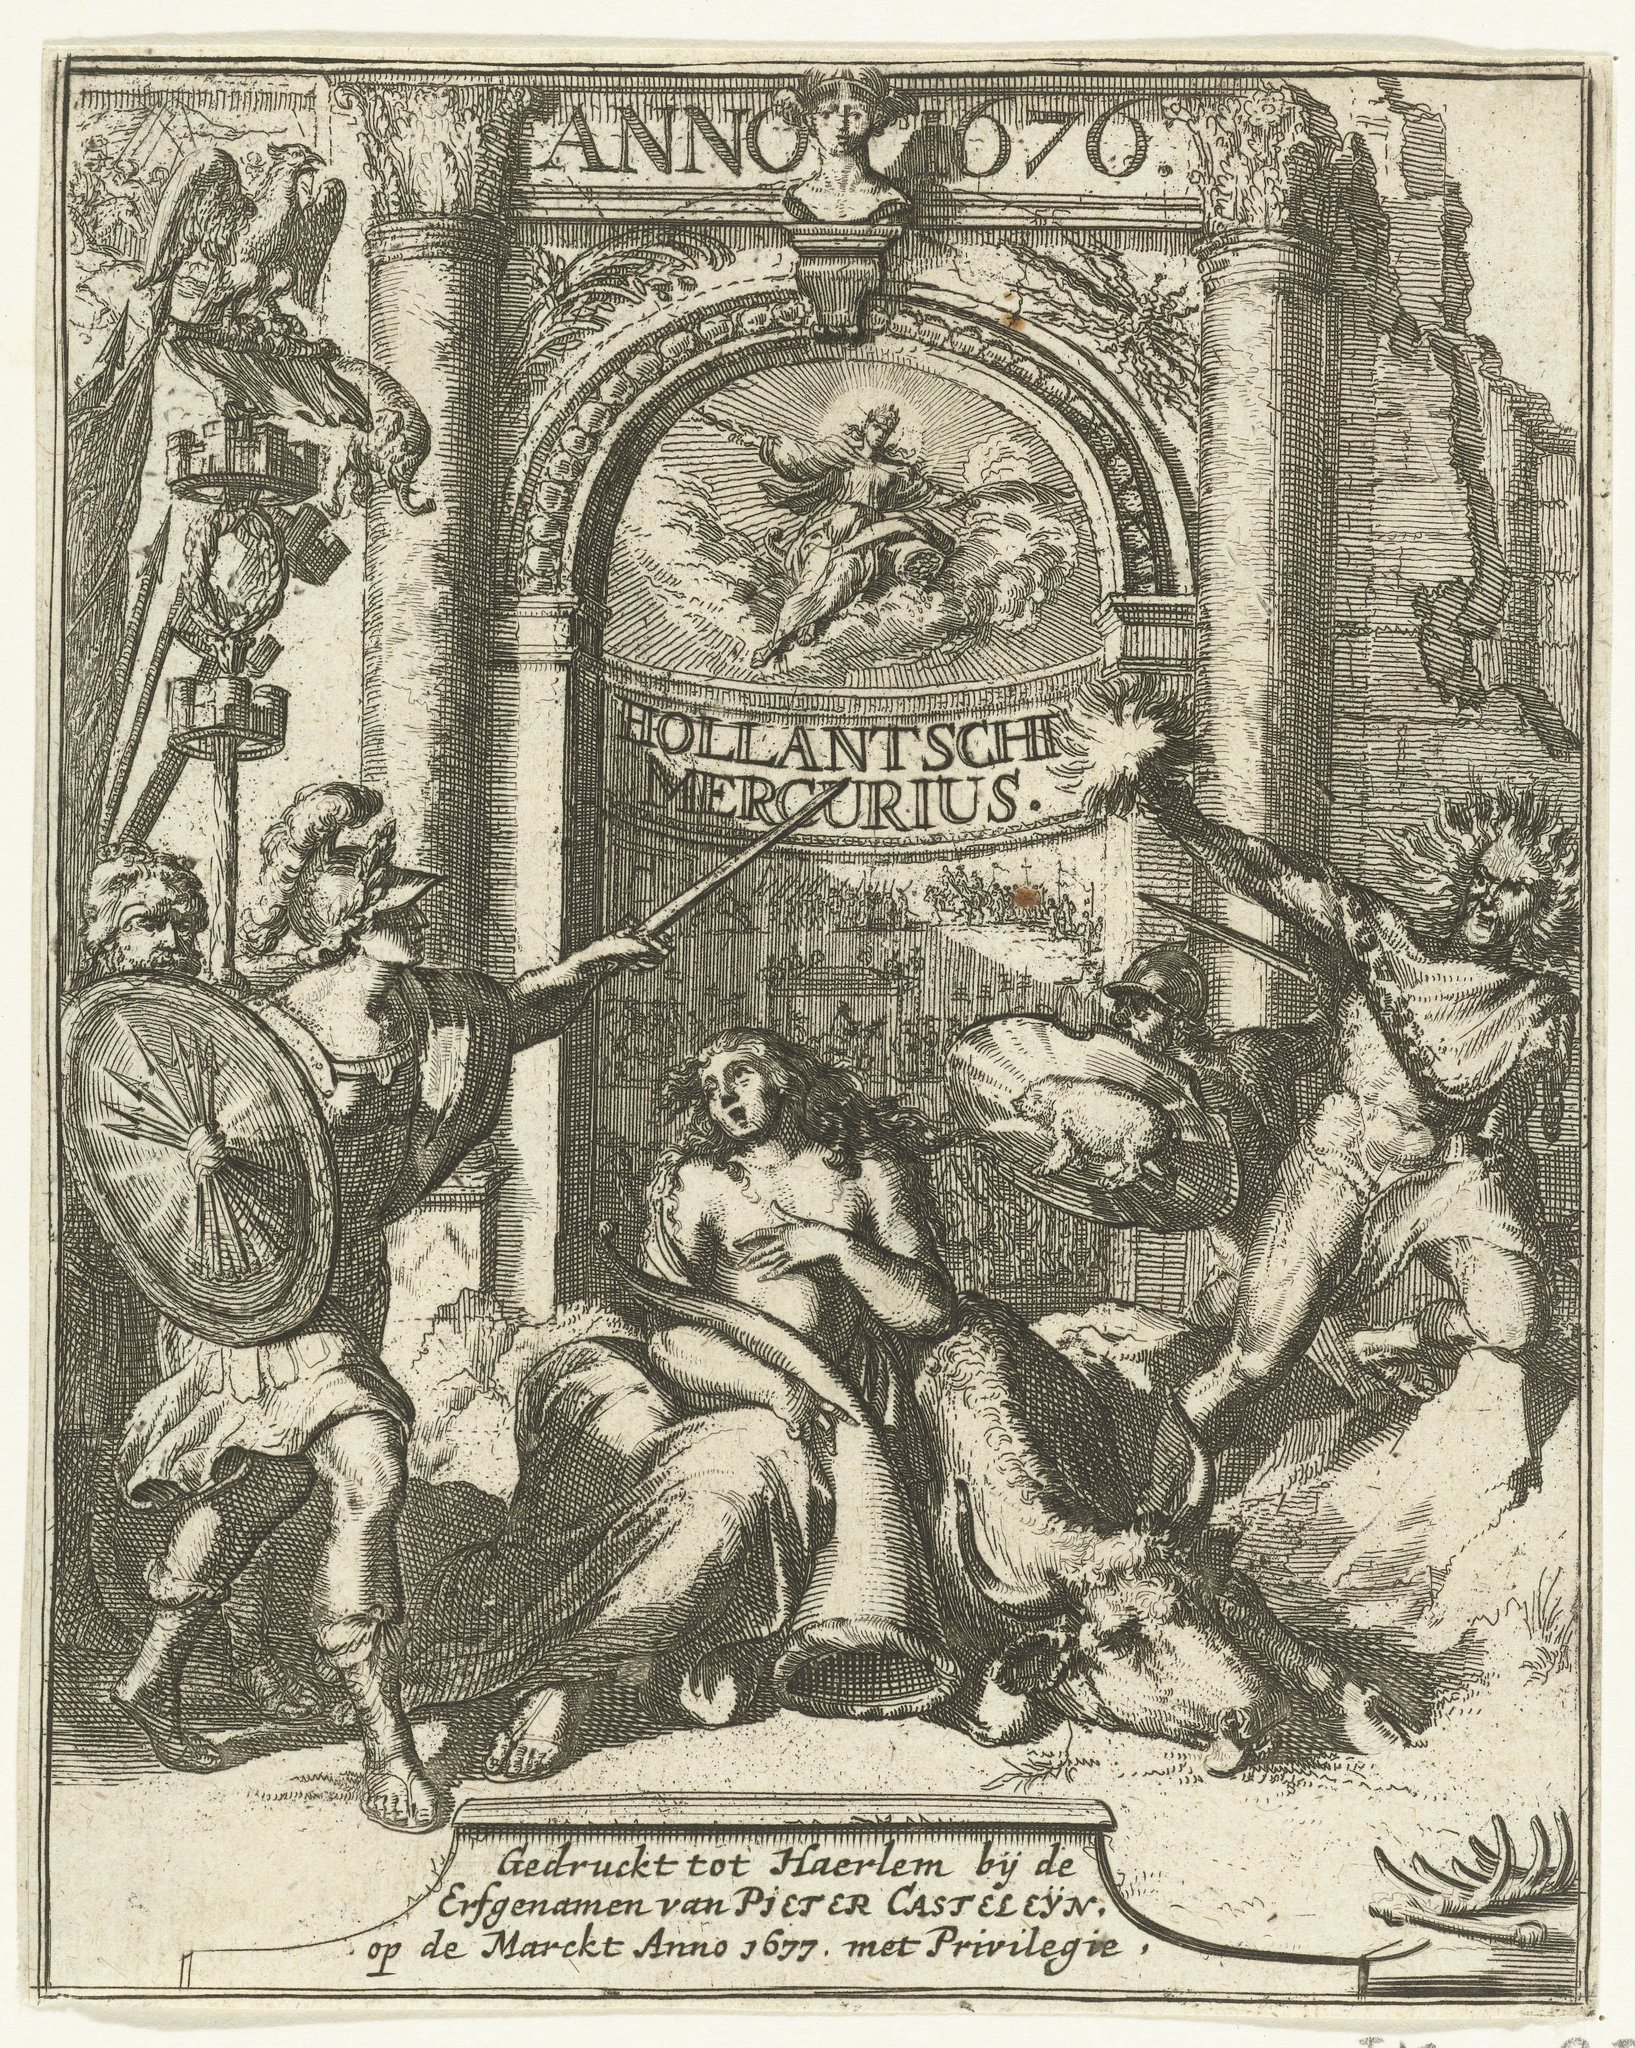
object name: titelblad, titelpagina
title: Titelpagina voor de Hollandsche Mercurius over het jaar 1676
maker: romeyn de hooghe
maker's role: draughtsman, goldsmith, painter, print maker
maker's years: 1645-1708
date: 1677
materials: paper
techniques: etching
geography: haarlem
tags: specific aspects, allegorical aspects of mercury; mercury as patron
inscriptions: date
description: Titelpagina voor de Hollandsche Mercurius over het jaar 1676. Mercurius strijdt als een Romeins soldaat tegen Geweld en Oorlog. In het midden een treurende Nederlandse Maagd naast een uitgeputte koe en een lege hoorn des overvloeds.